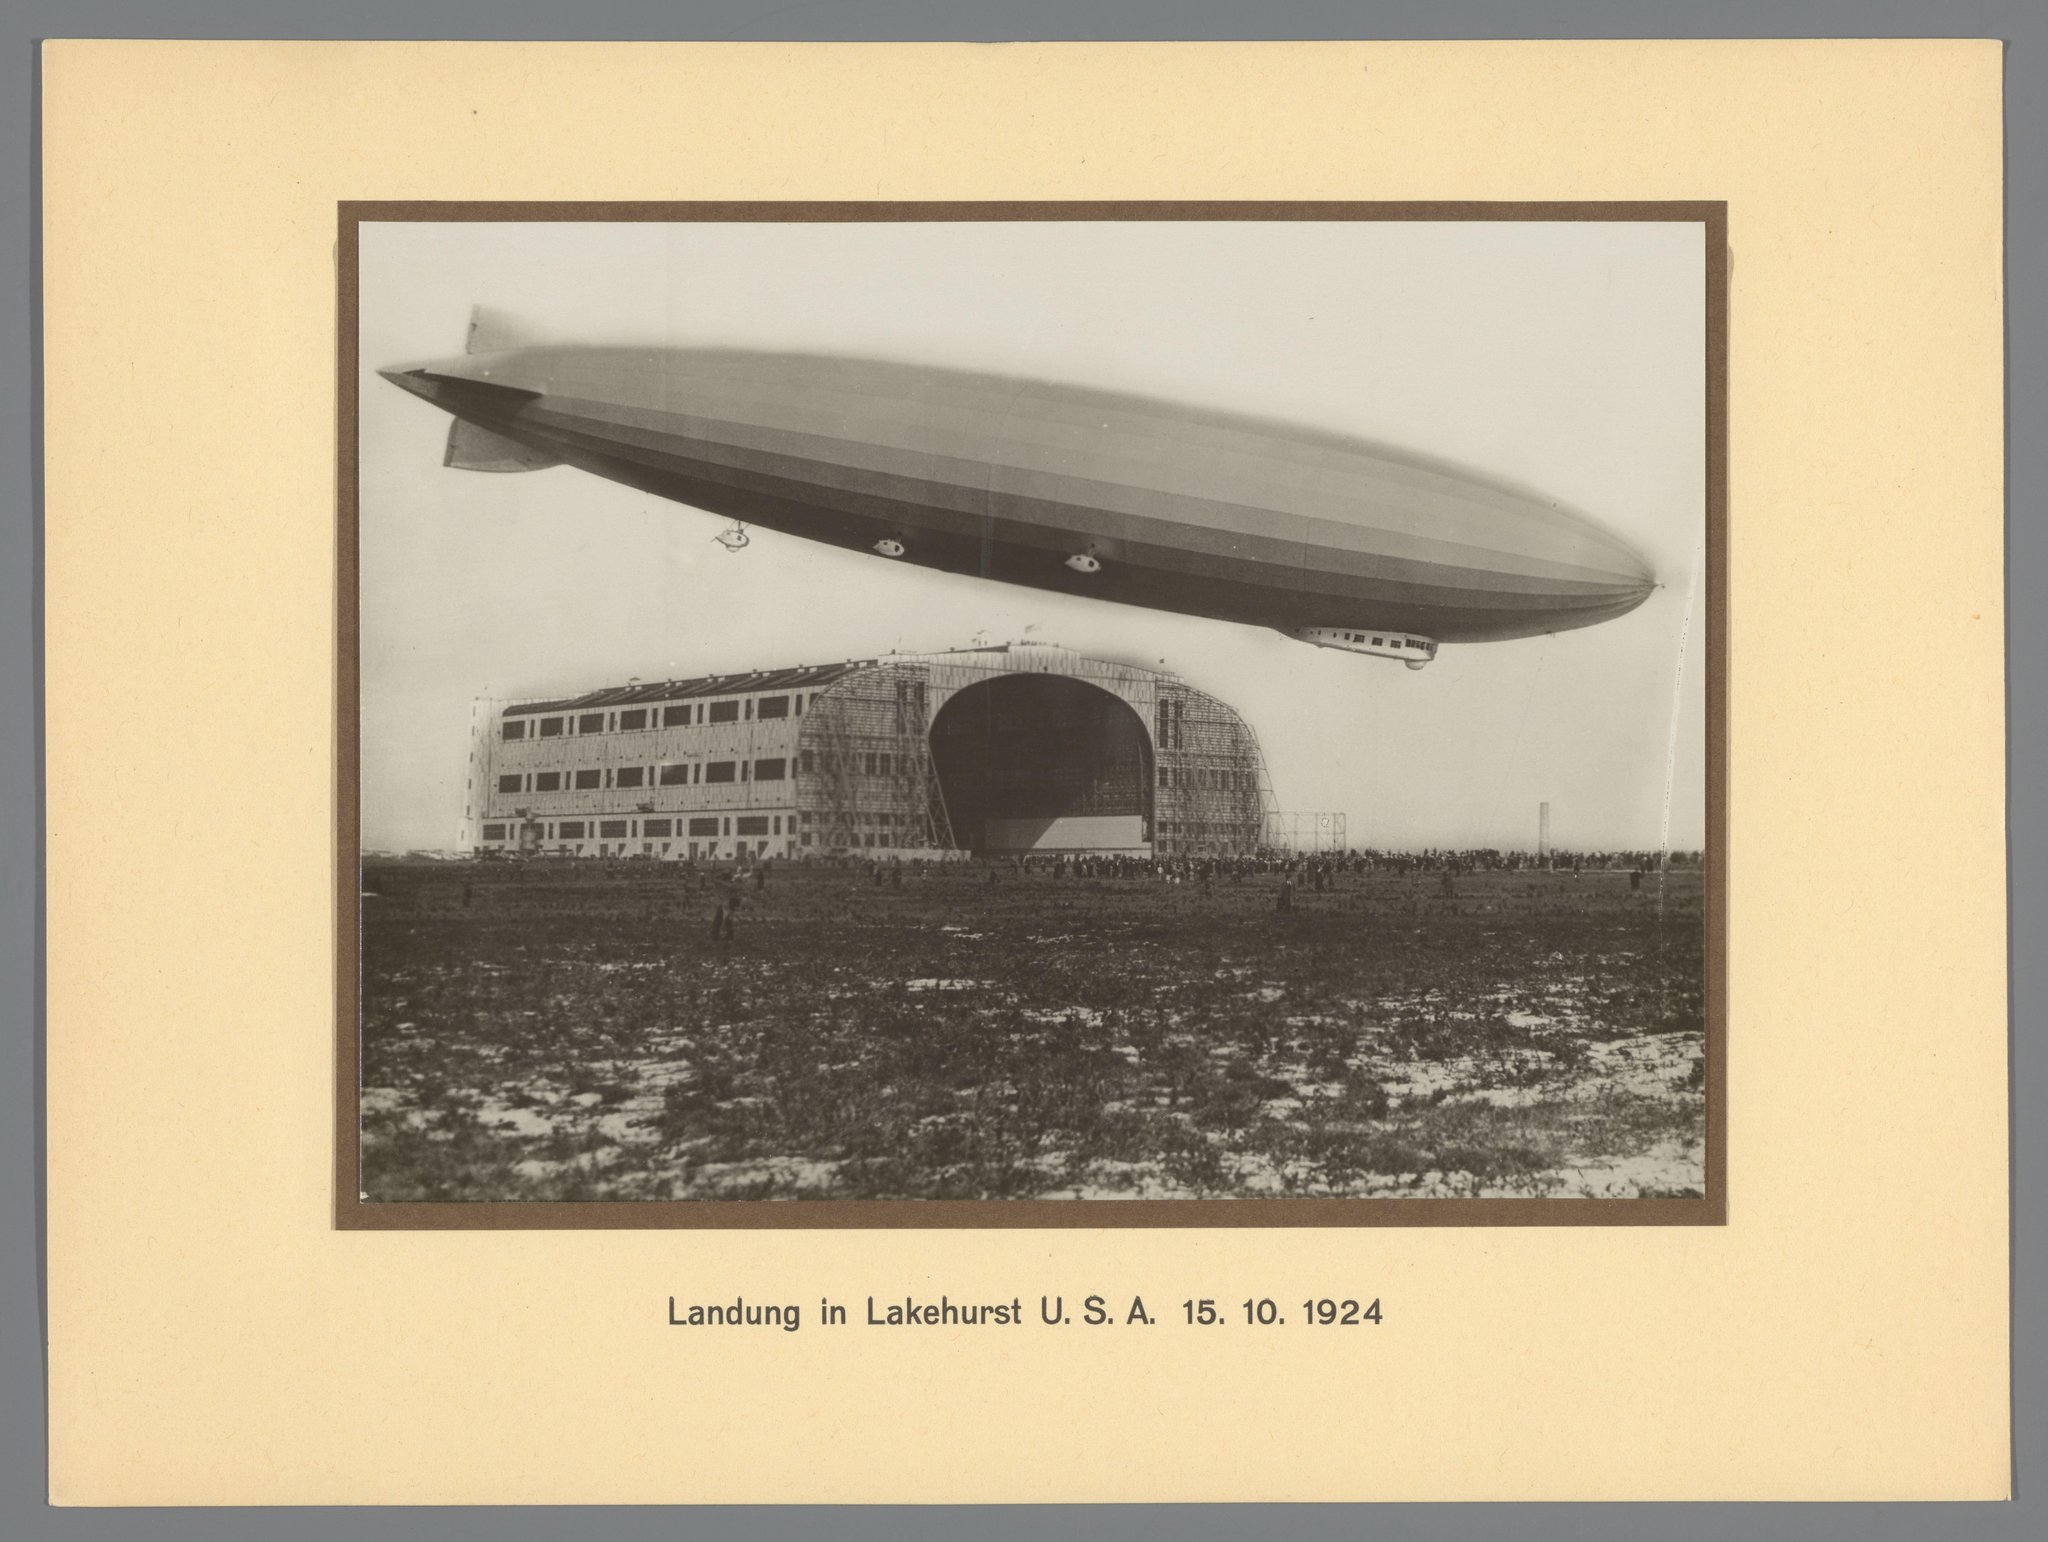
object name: photograph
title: Landing van de zeppelin in de VS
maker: Anonymous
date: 1924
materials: cardboard, photographic support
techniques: gelatin silver print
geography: friedrichshafen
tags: 46c35 airship, zeppelin, hangar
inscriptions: date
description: Landing van de zeppelin in Lakehurst, in de Verenigde Staten, op 15 oktober 1924. Onderdeel van een map twintig productfoto's van het Zeppelinluchtschip LZ 126.